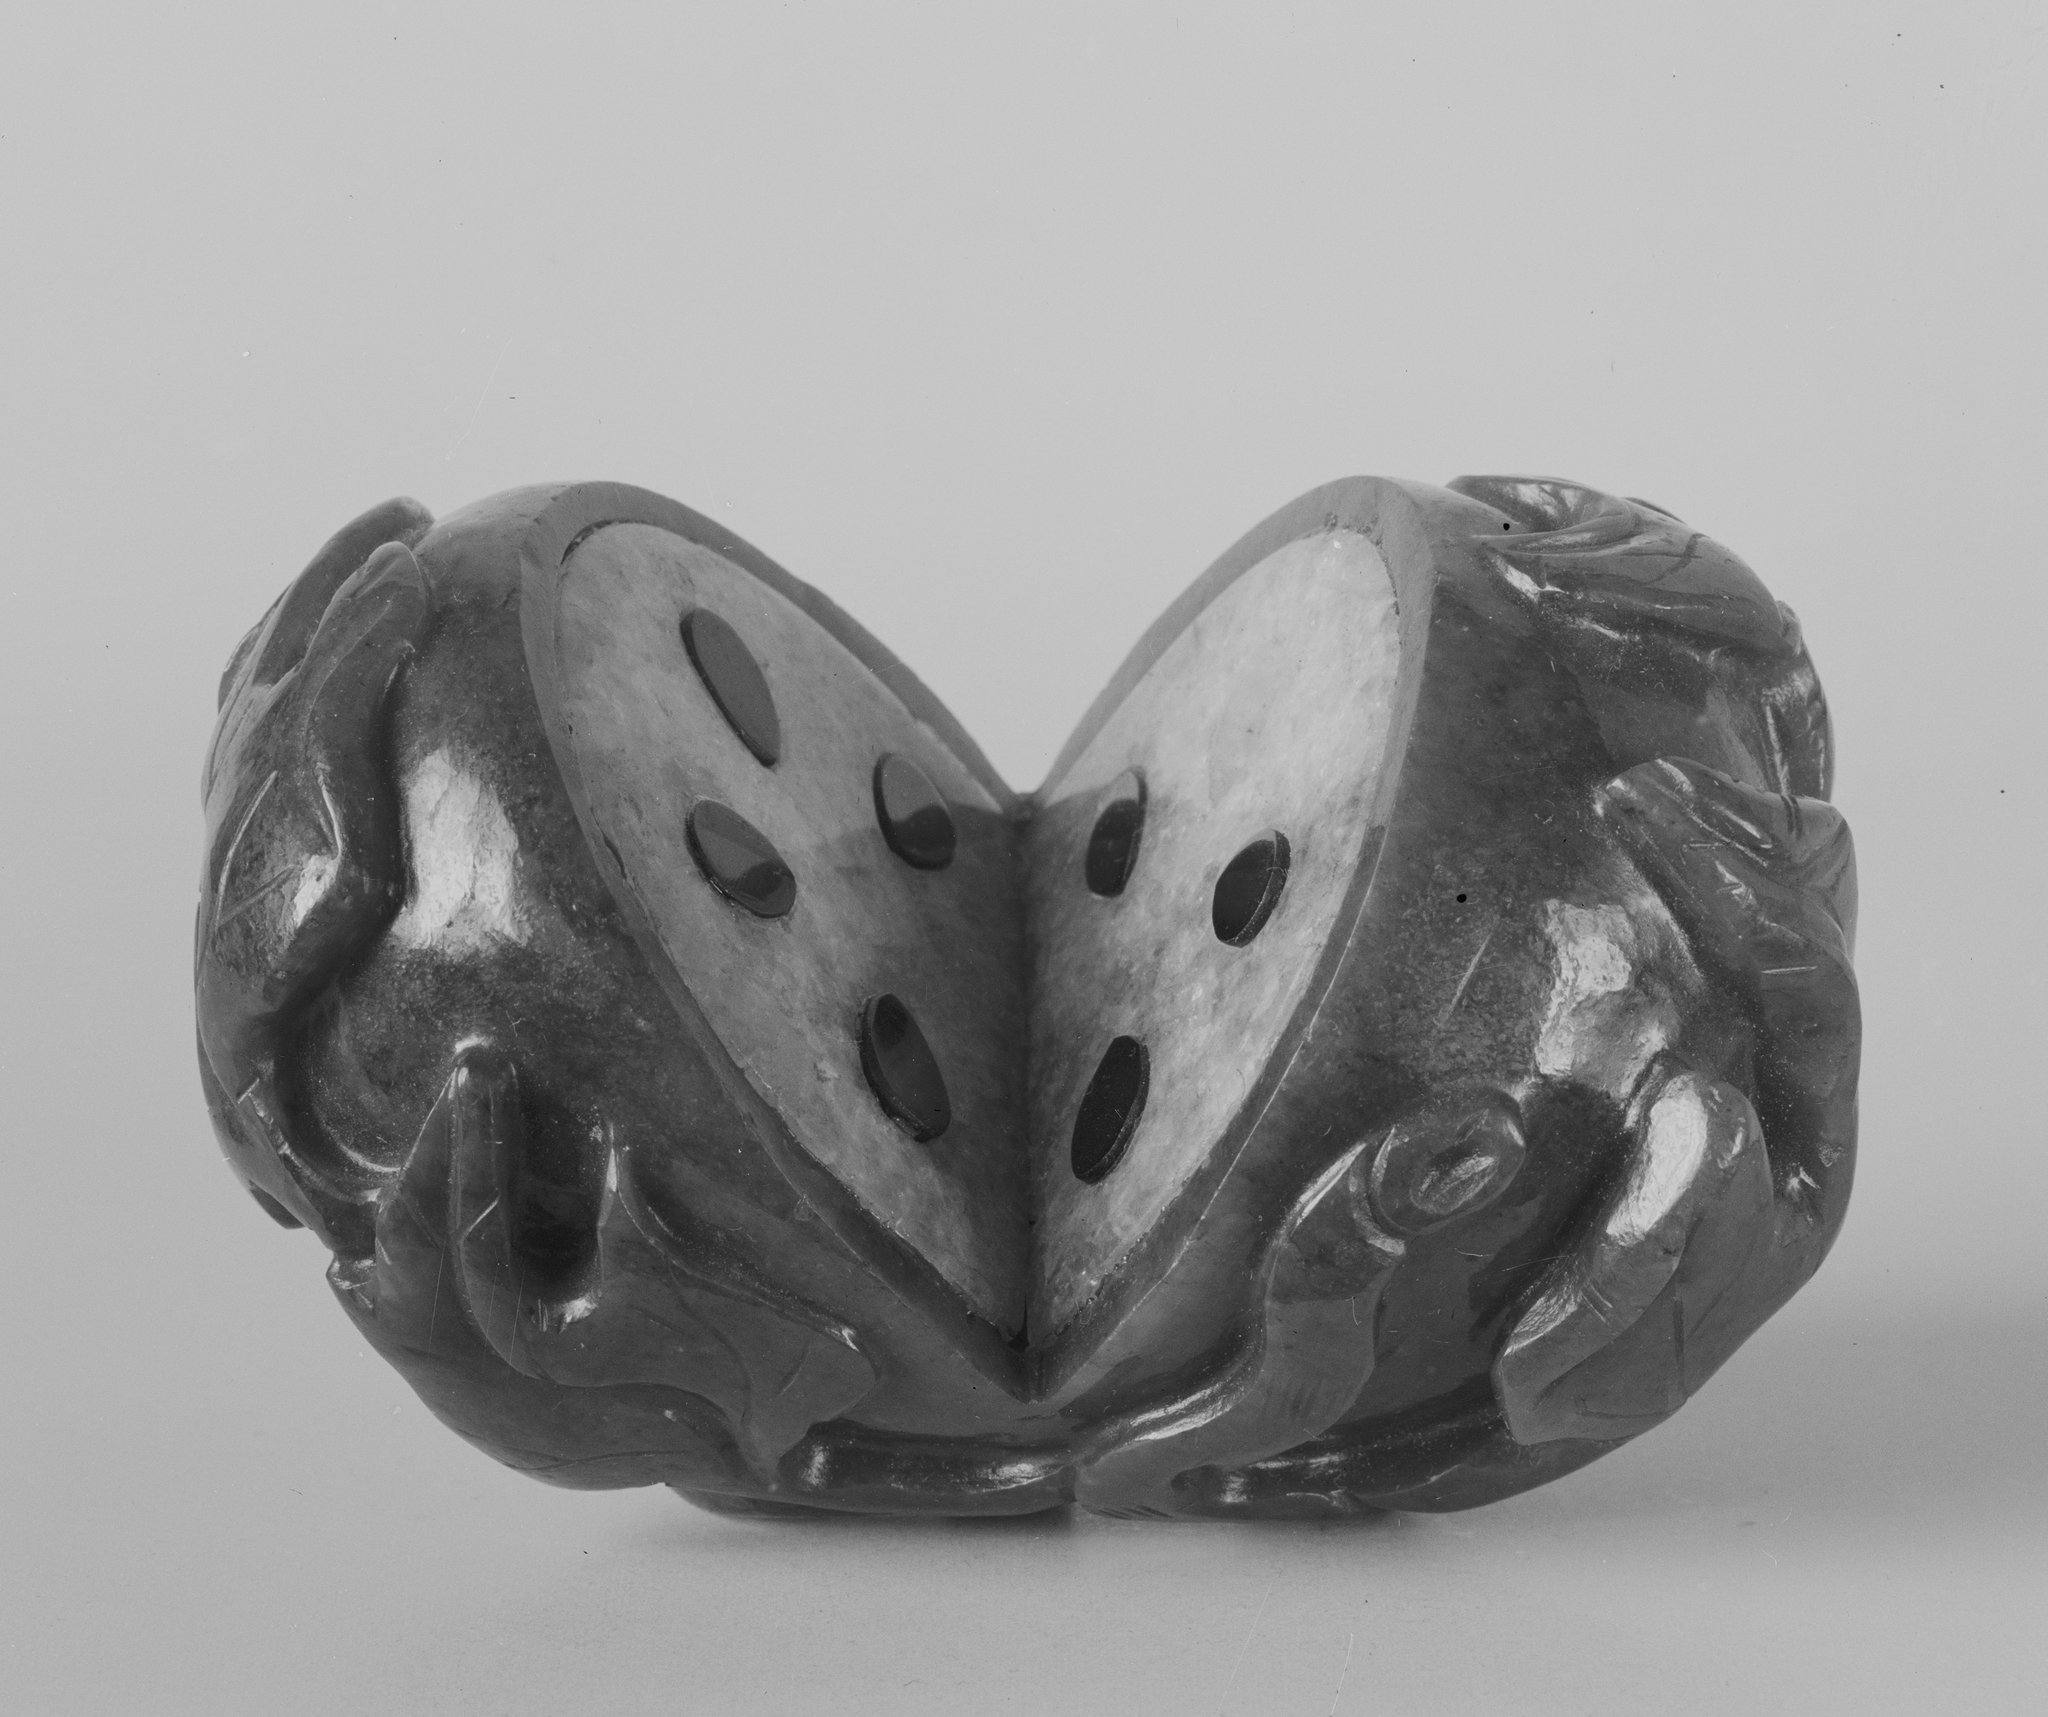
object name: ornament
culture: chinese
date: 1736-1795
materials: jade, onyx, quartz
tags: fruit